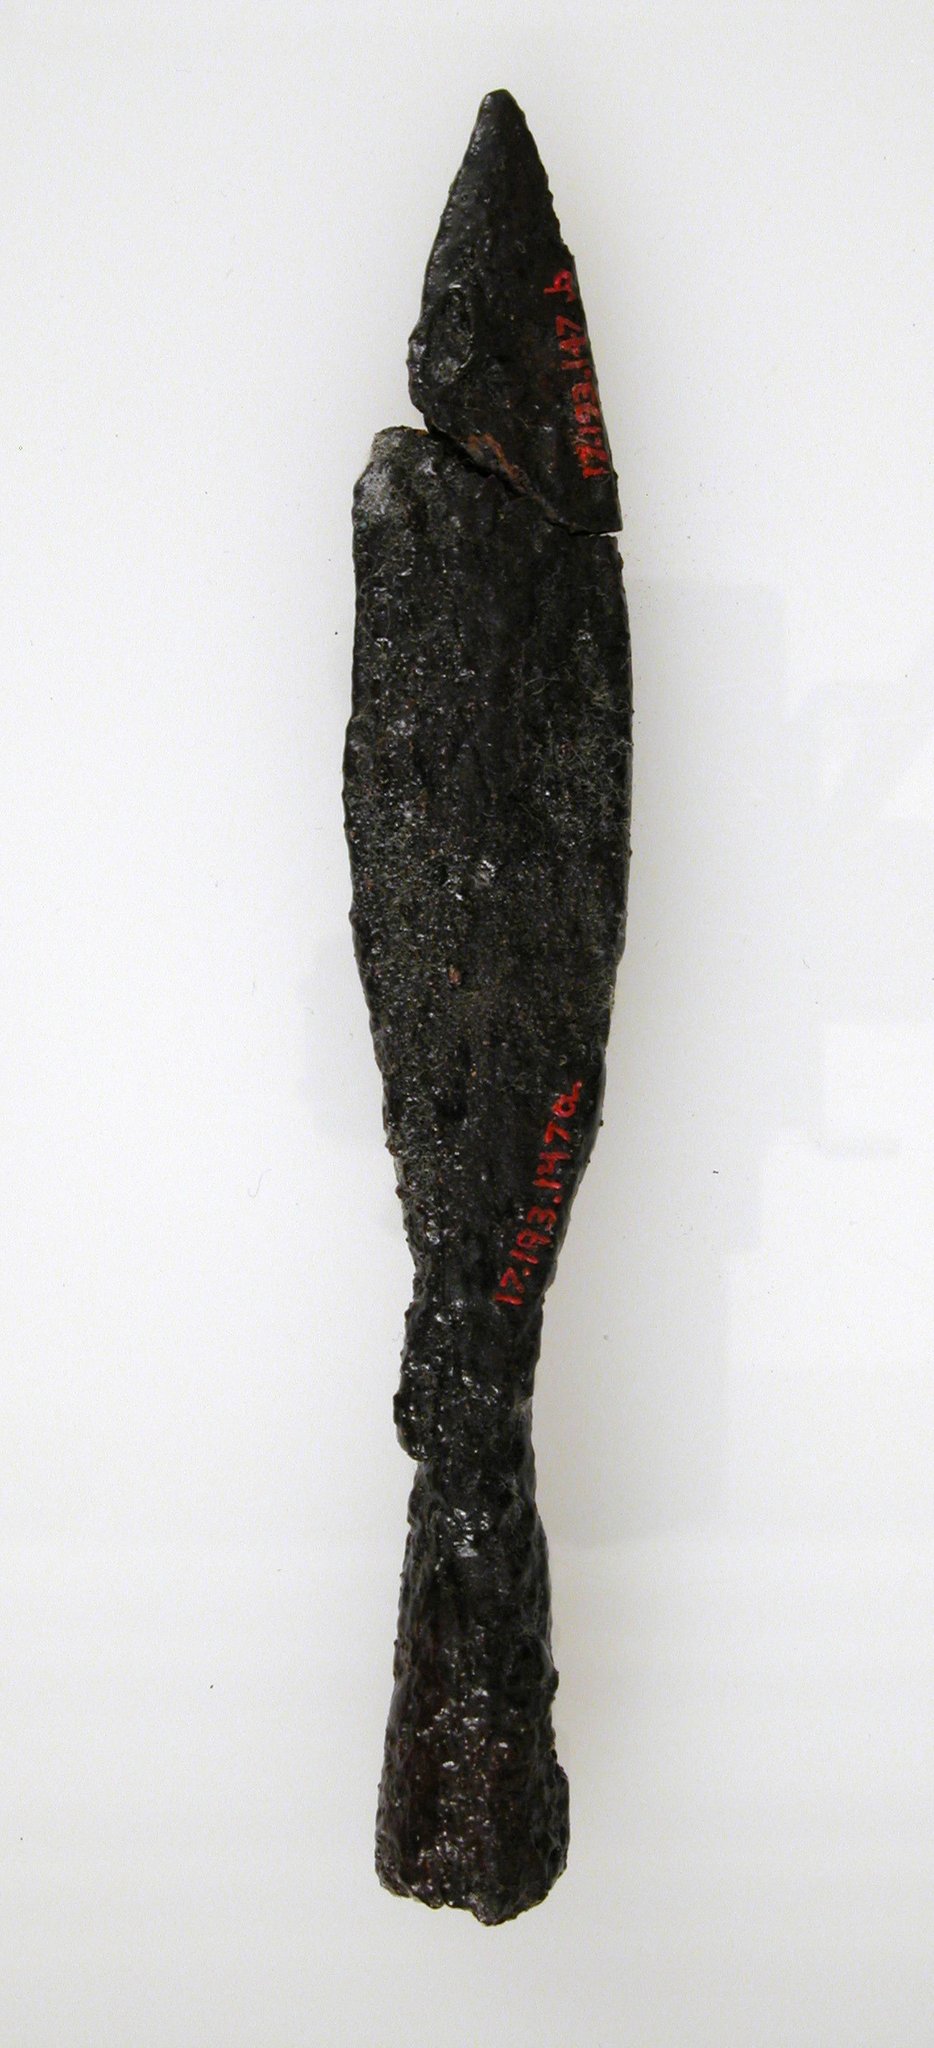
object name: spearhead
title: Small Spearhead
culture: frankish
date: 500-600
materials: iron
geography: germany